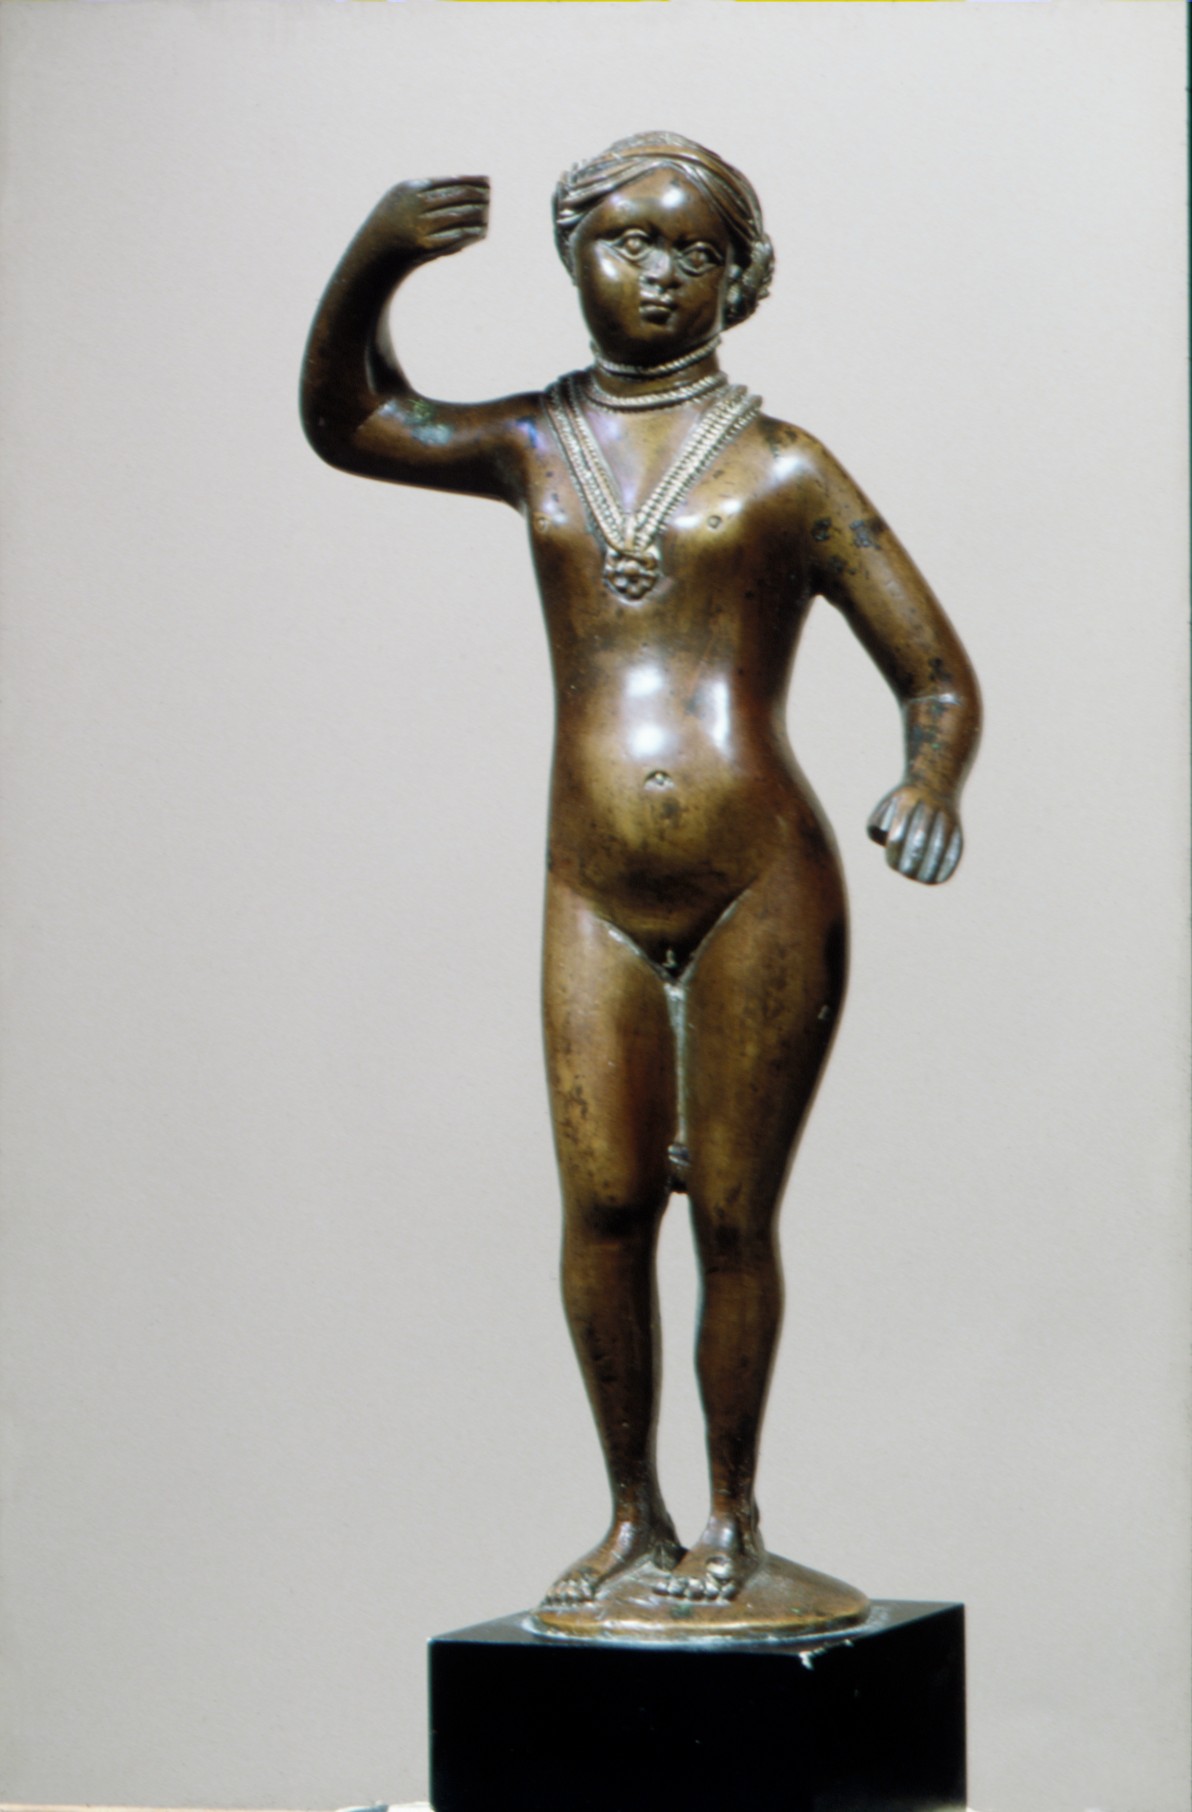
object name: statuette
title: Venus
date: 1501-1533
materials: bronze, patina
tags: venus